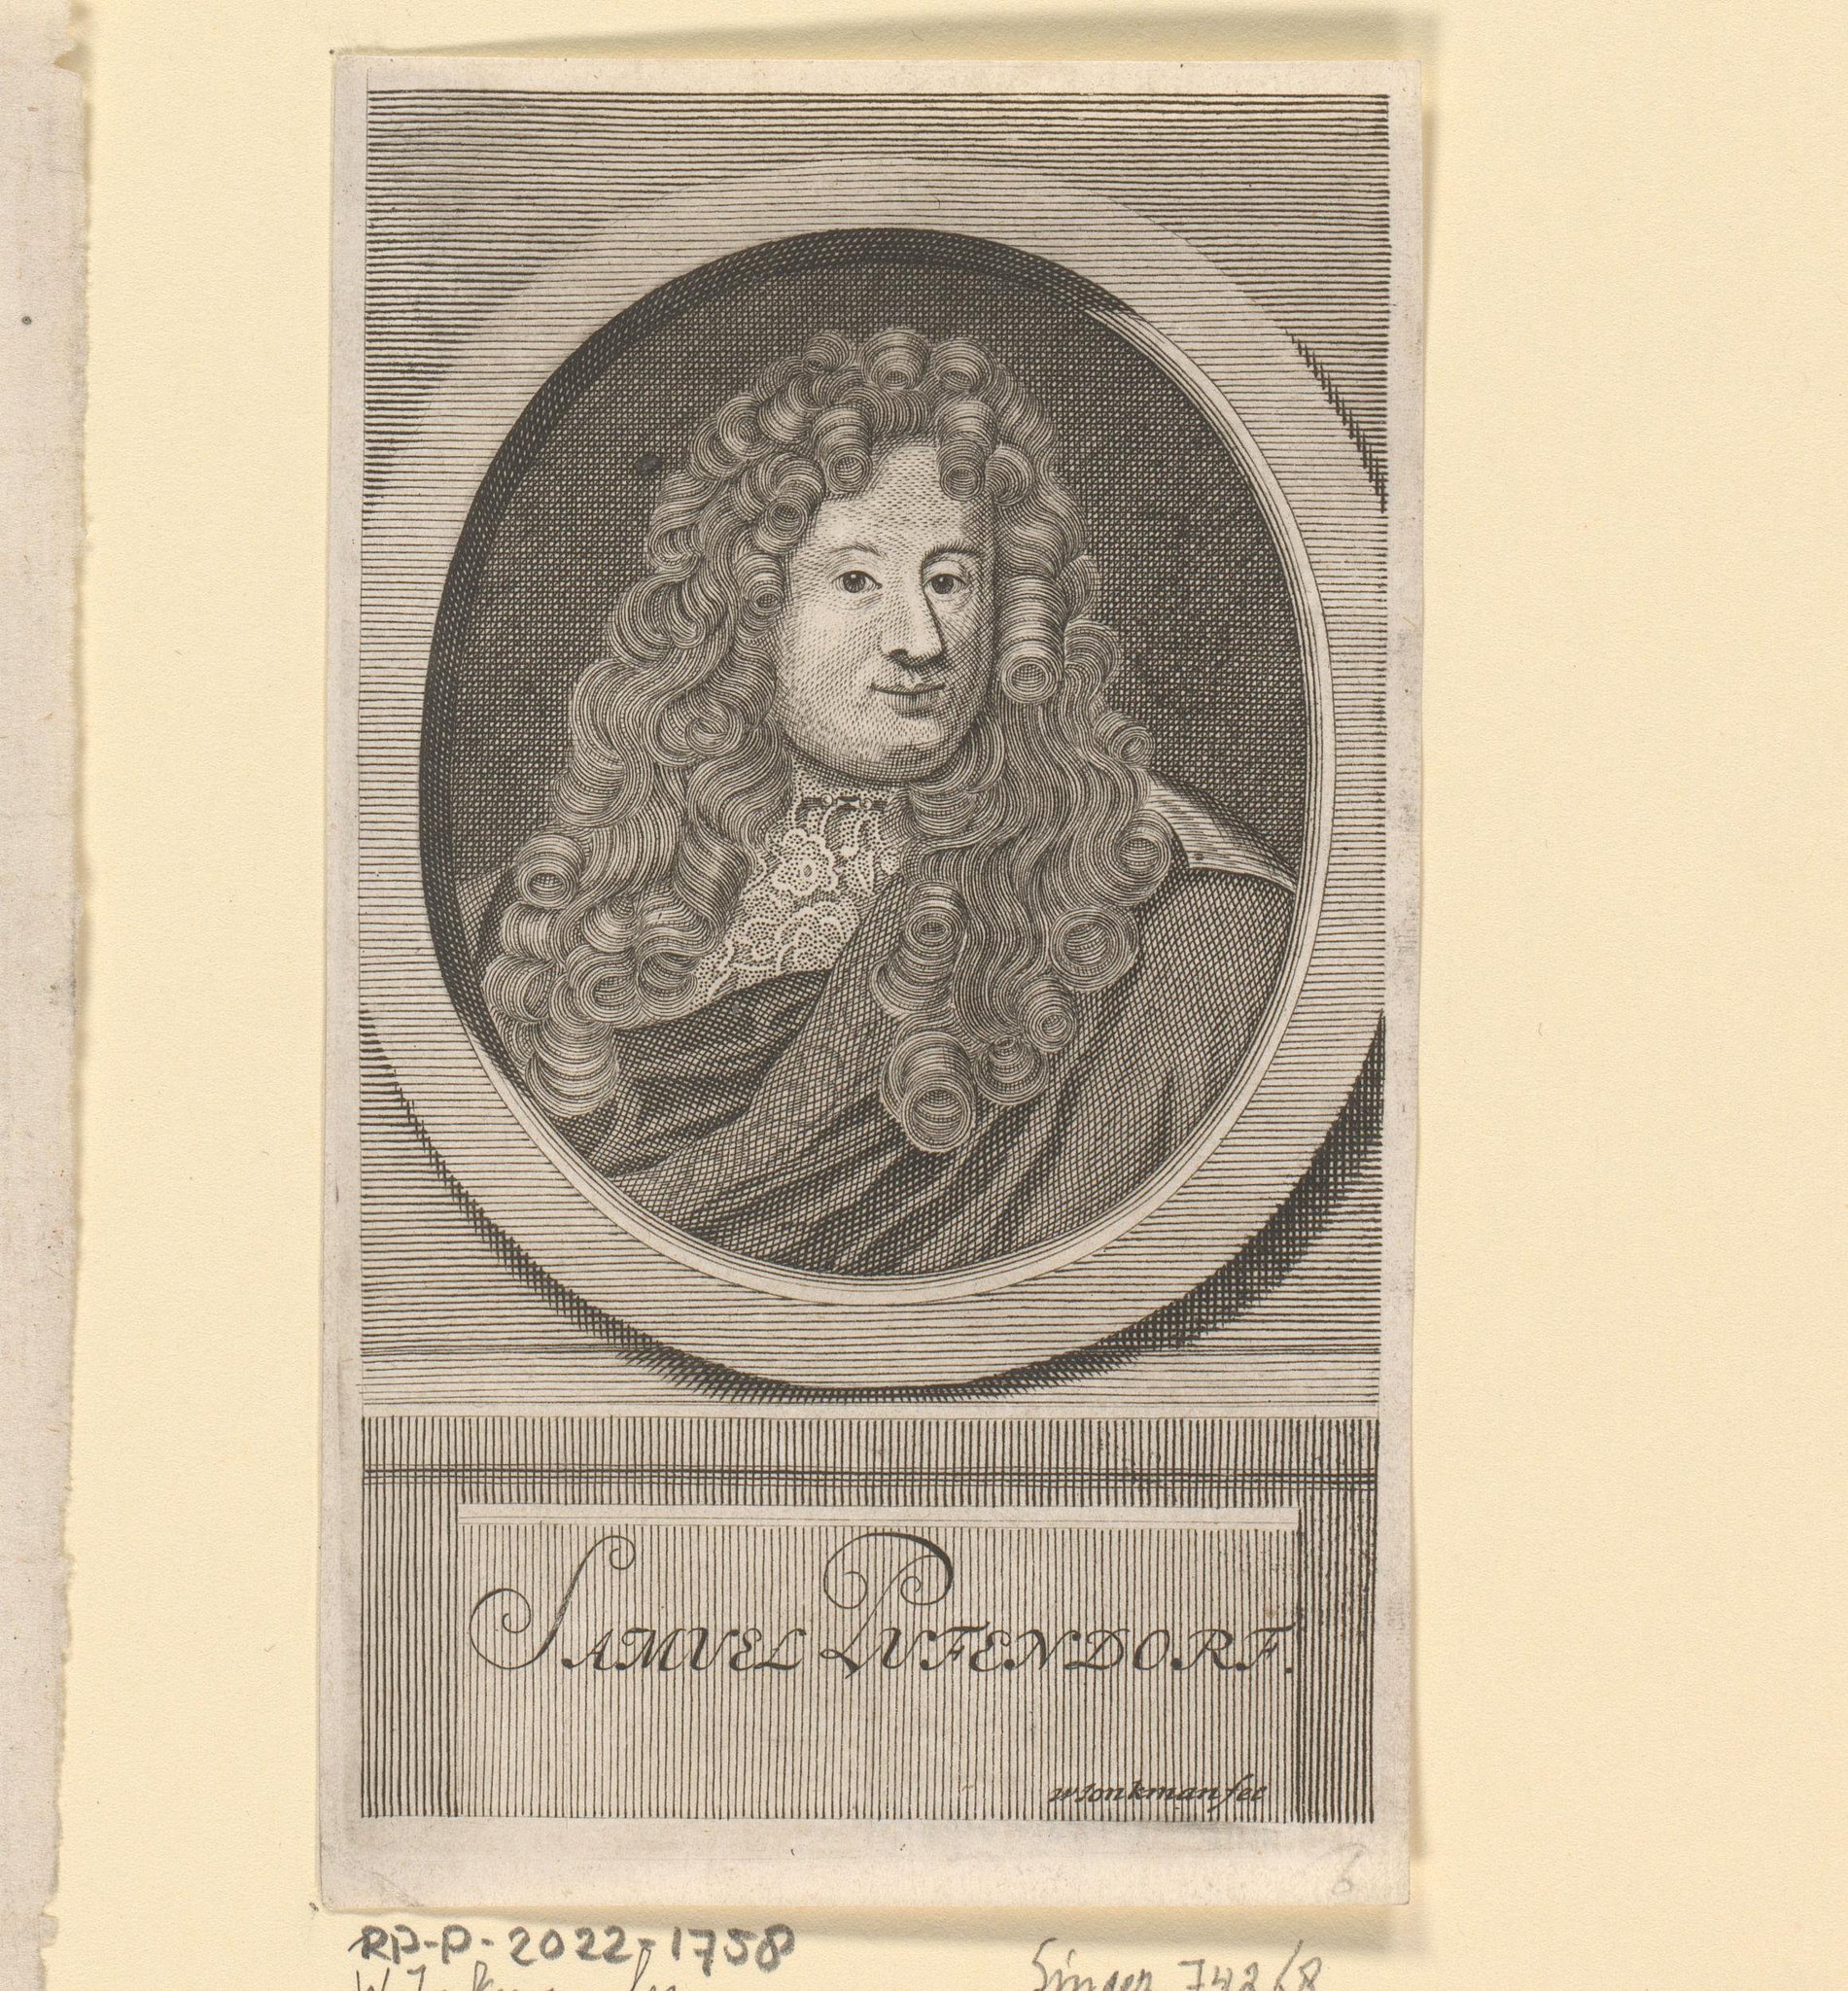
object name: print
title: Portret van Samuel von Pufendorf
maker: wouter jongman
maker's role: print maker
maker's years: -1753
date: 1732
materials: paper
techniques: engraving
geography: amsterdam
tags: history and archaeology (+ portrait of scholar, scientist), scholar, philosopher, historical persons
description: Prent waarschijnlijk uit: Pufendorf, Samuel von. Histoire de Suède, avant et depuis la fondation de la monarchie. Nouvelle édition. Amsterdam: Zacharie Chatelain 1732, dl. 3. Prent ook gebruikt in: Pufendorf, Samuel von. Histoire de Suède, avant et depuis la fondation de la monarchie. Nouvelle édition. Amsterdam: Zacharie Chatelain, 1748, dl. 1.